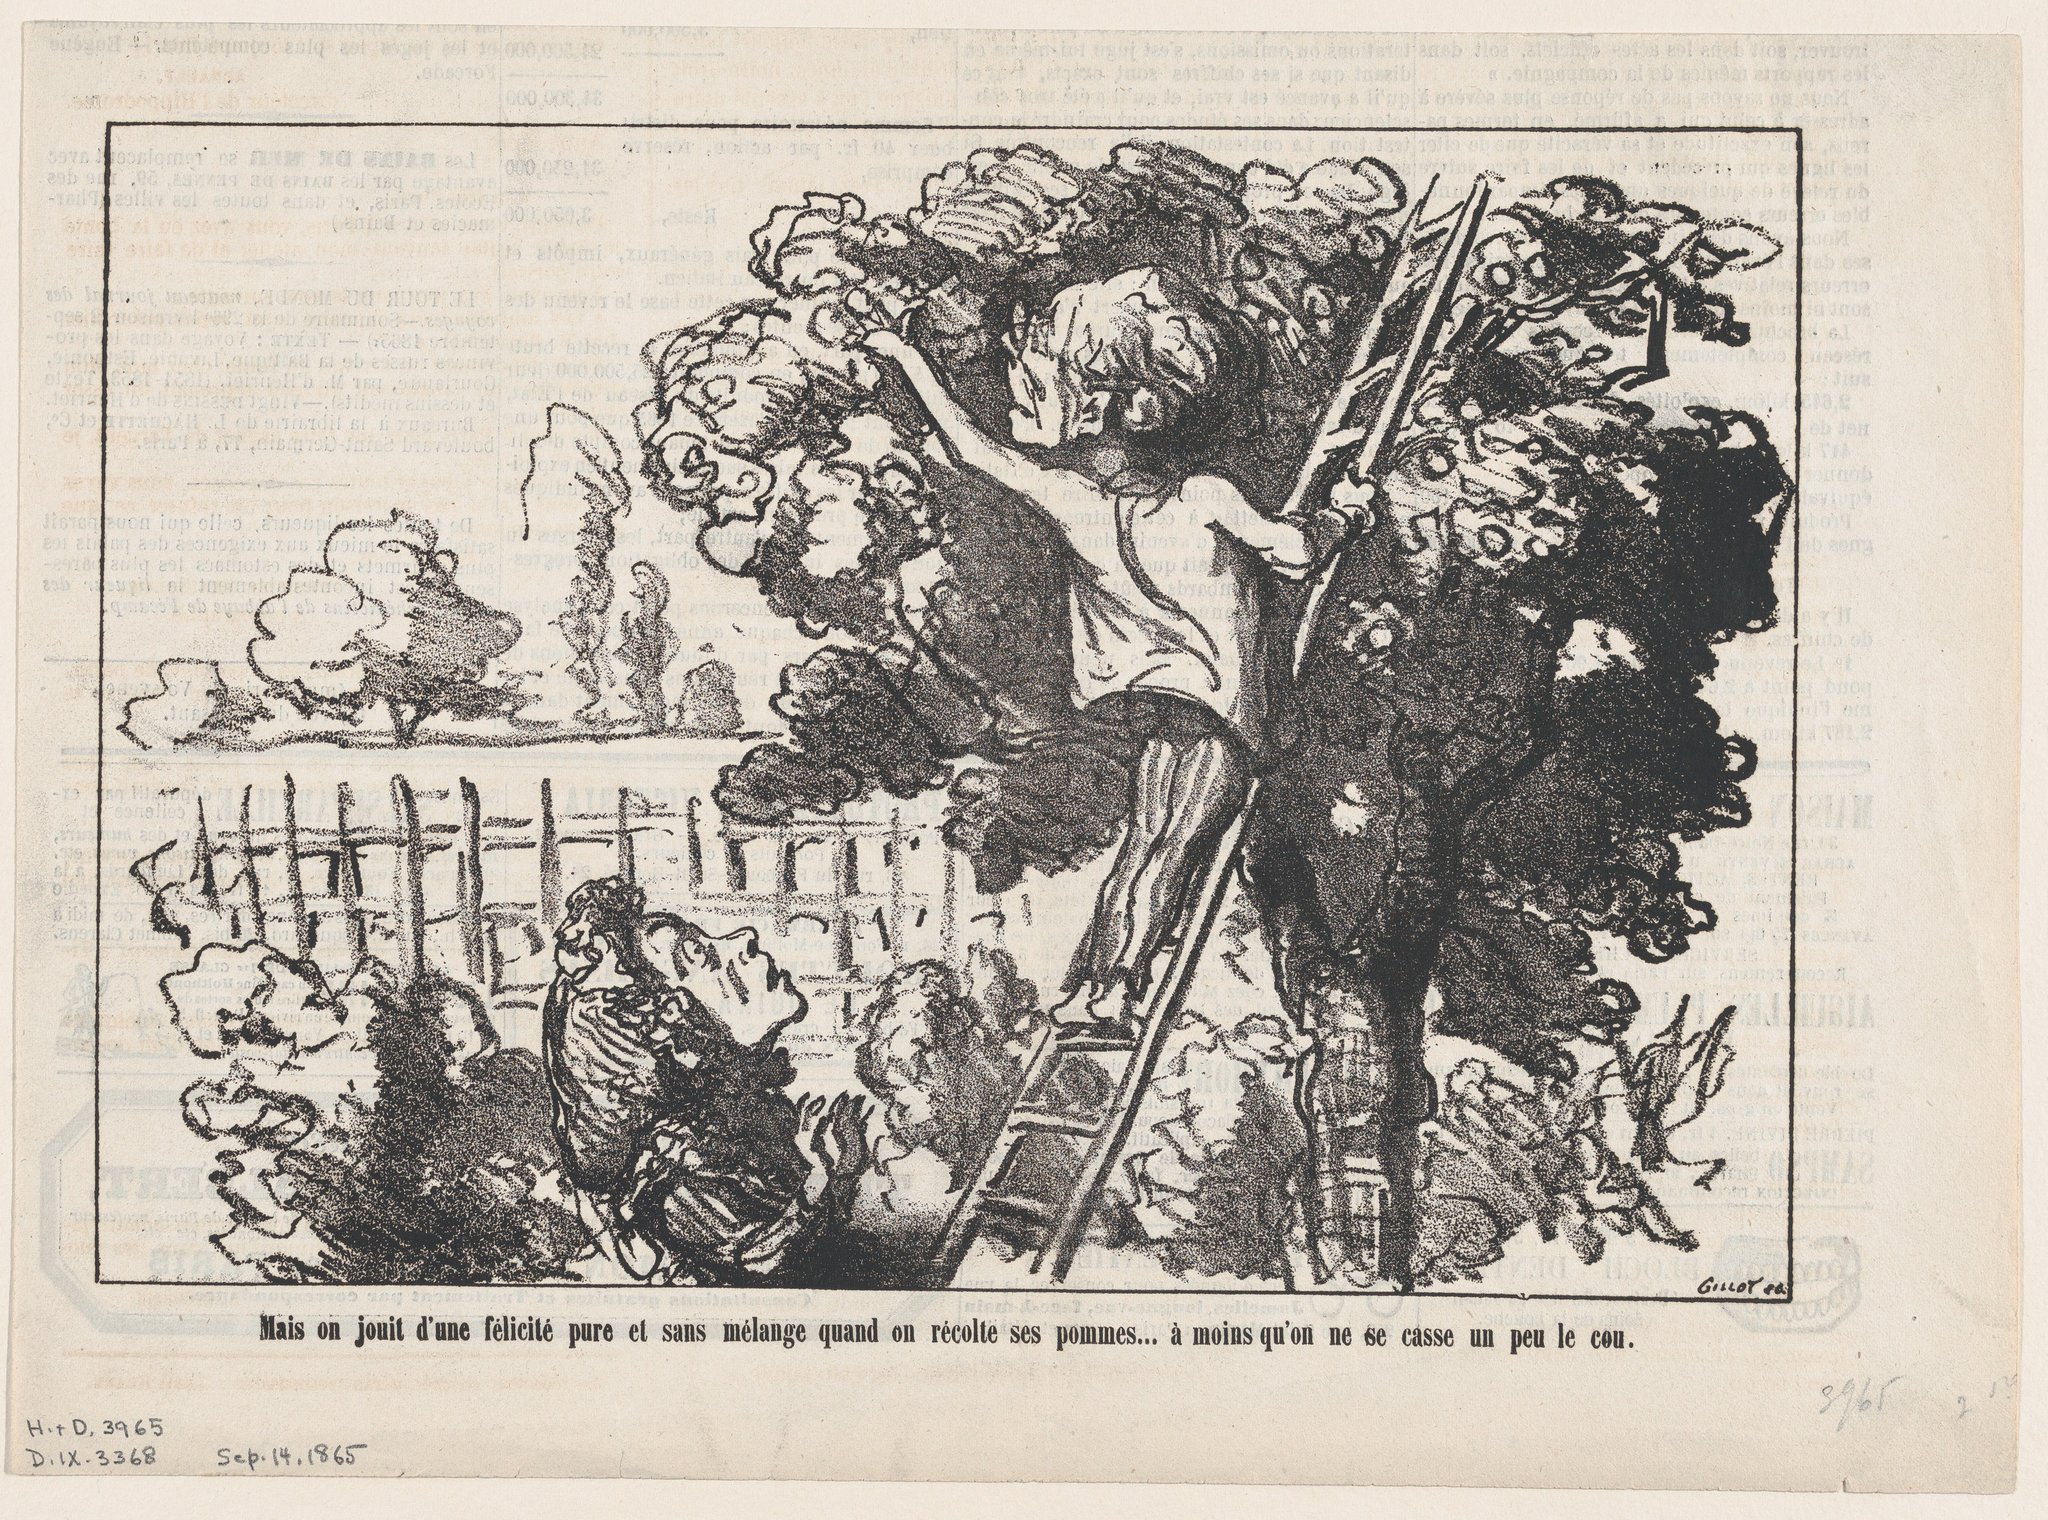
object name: print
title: One rejoices in a pure, unspoiled happiness when harvesting ones own apples... at least as long as one doesn't break one's neck, from "The joys of country life"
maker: honoré daumier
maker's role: artist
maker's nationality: french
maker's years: 1808-1879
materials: paper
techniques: lithograph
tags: men,women,trees,working,ladders